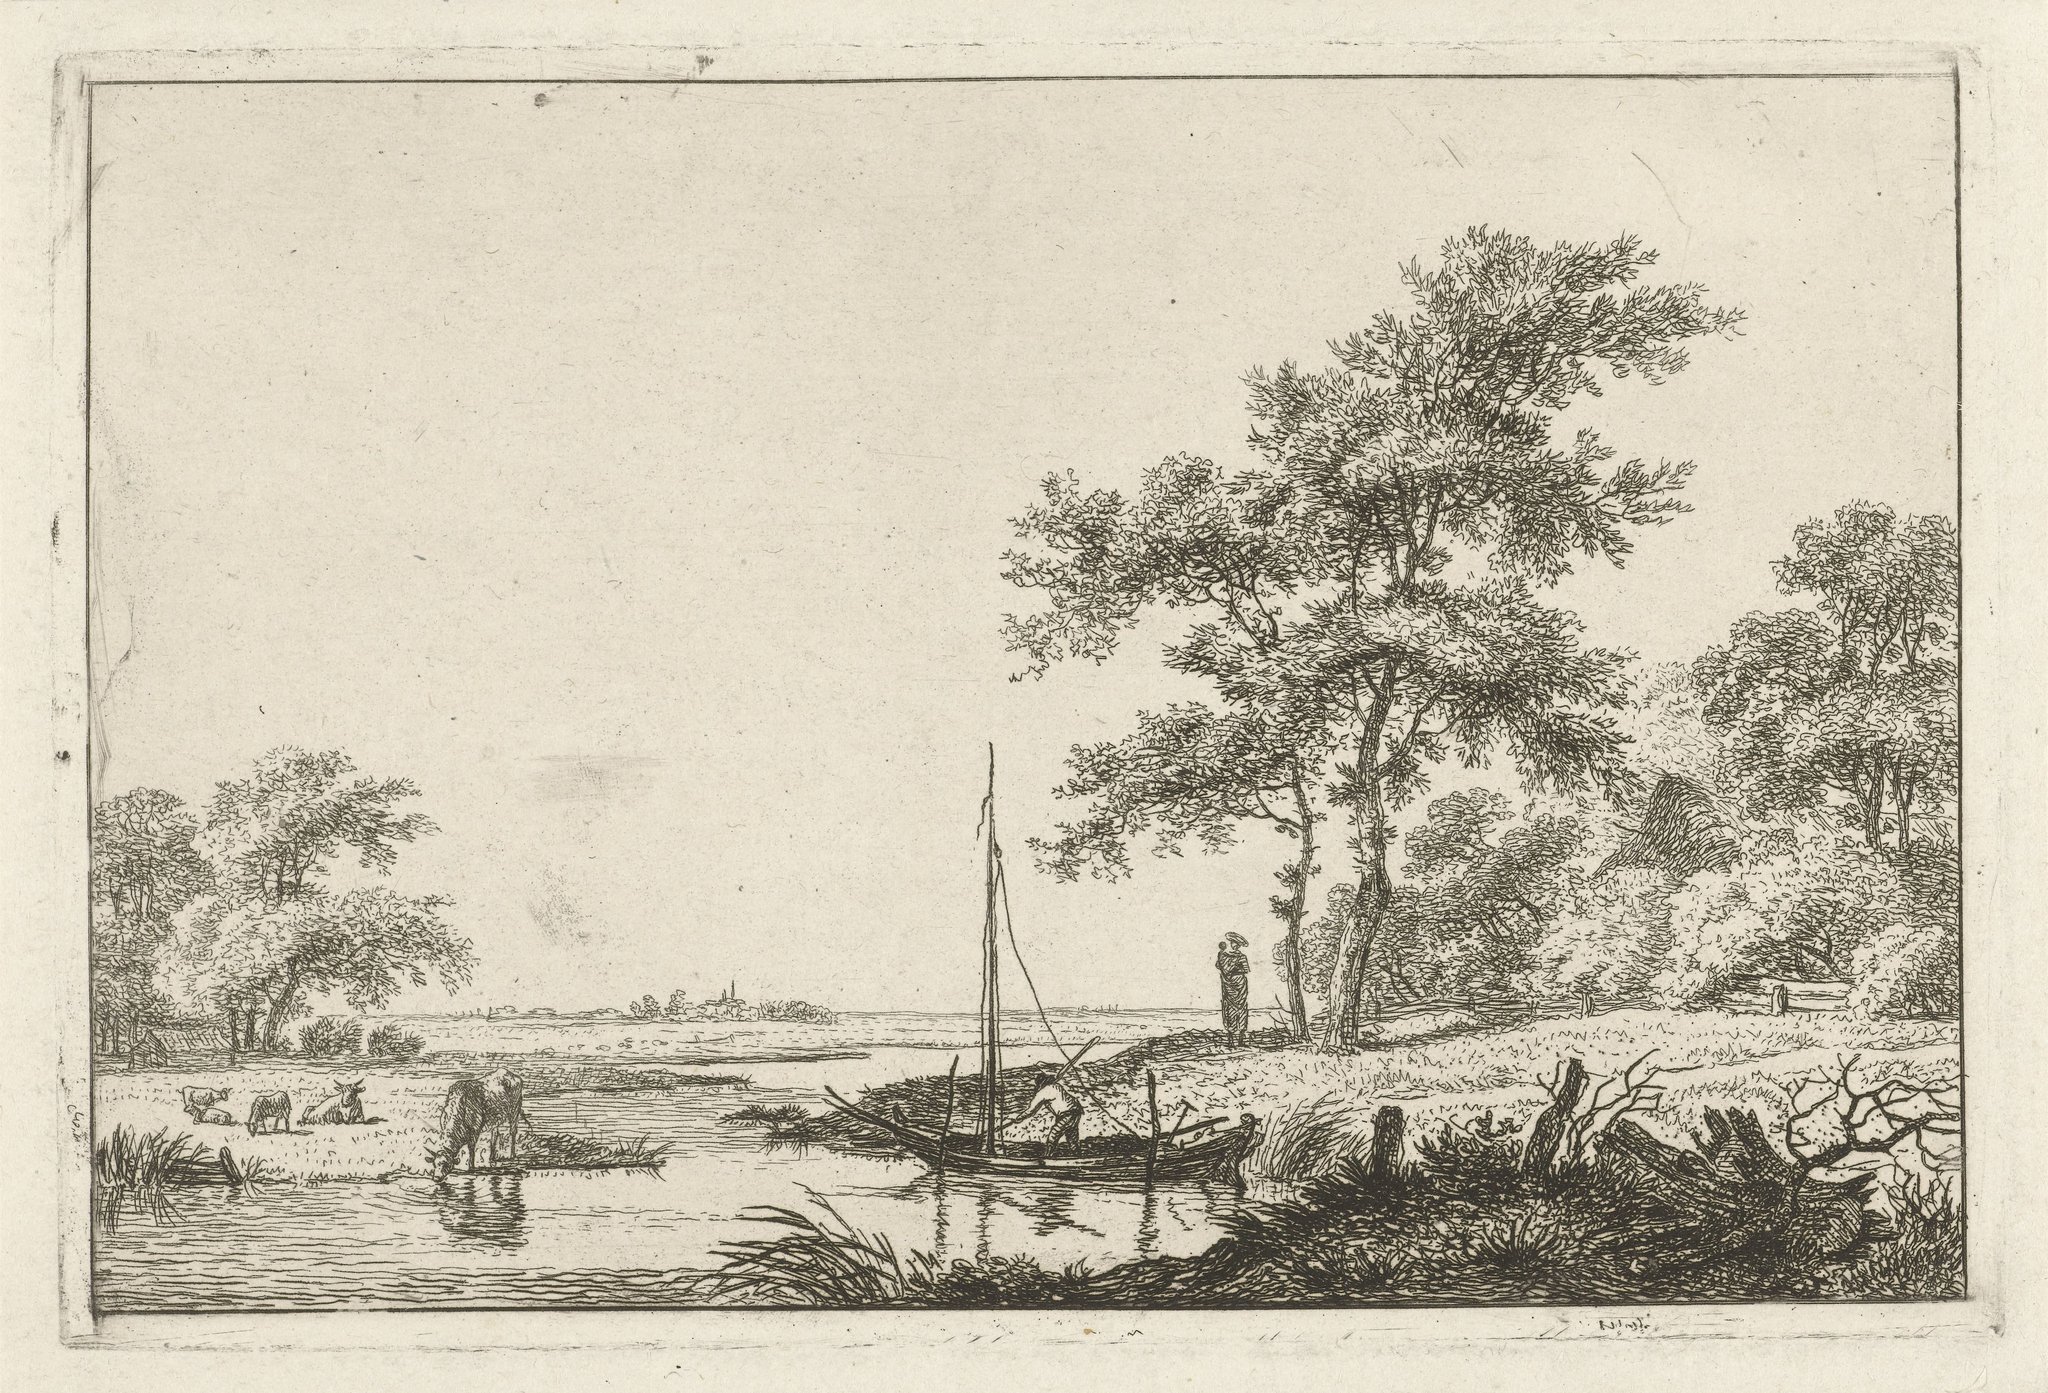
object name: print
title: Landschap met schuitje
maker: hermanus fock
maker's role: conservator, draughtsman, painter, print maker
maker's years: 1766-1822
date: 1781-1822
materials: paper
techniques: etching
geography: amsterdam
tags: river (+ landscape with figures, staffage)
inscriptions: collector's mark: Lugt 2228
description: Een rivierlandschap met koeien en een zeilbootje. Op de oever van de rivier, bij twee bomen, staat een persoon met een kind in de armen. Tussen de bomen op de achtergrond het dak van een boerderij.